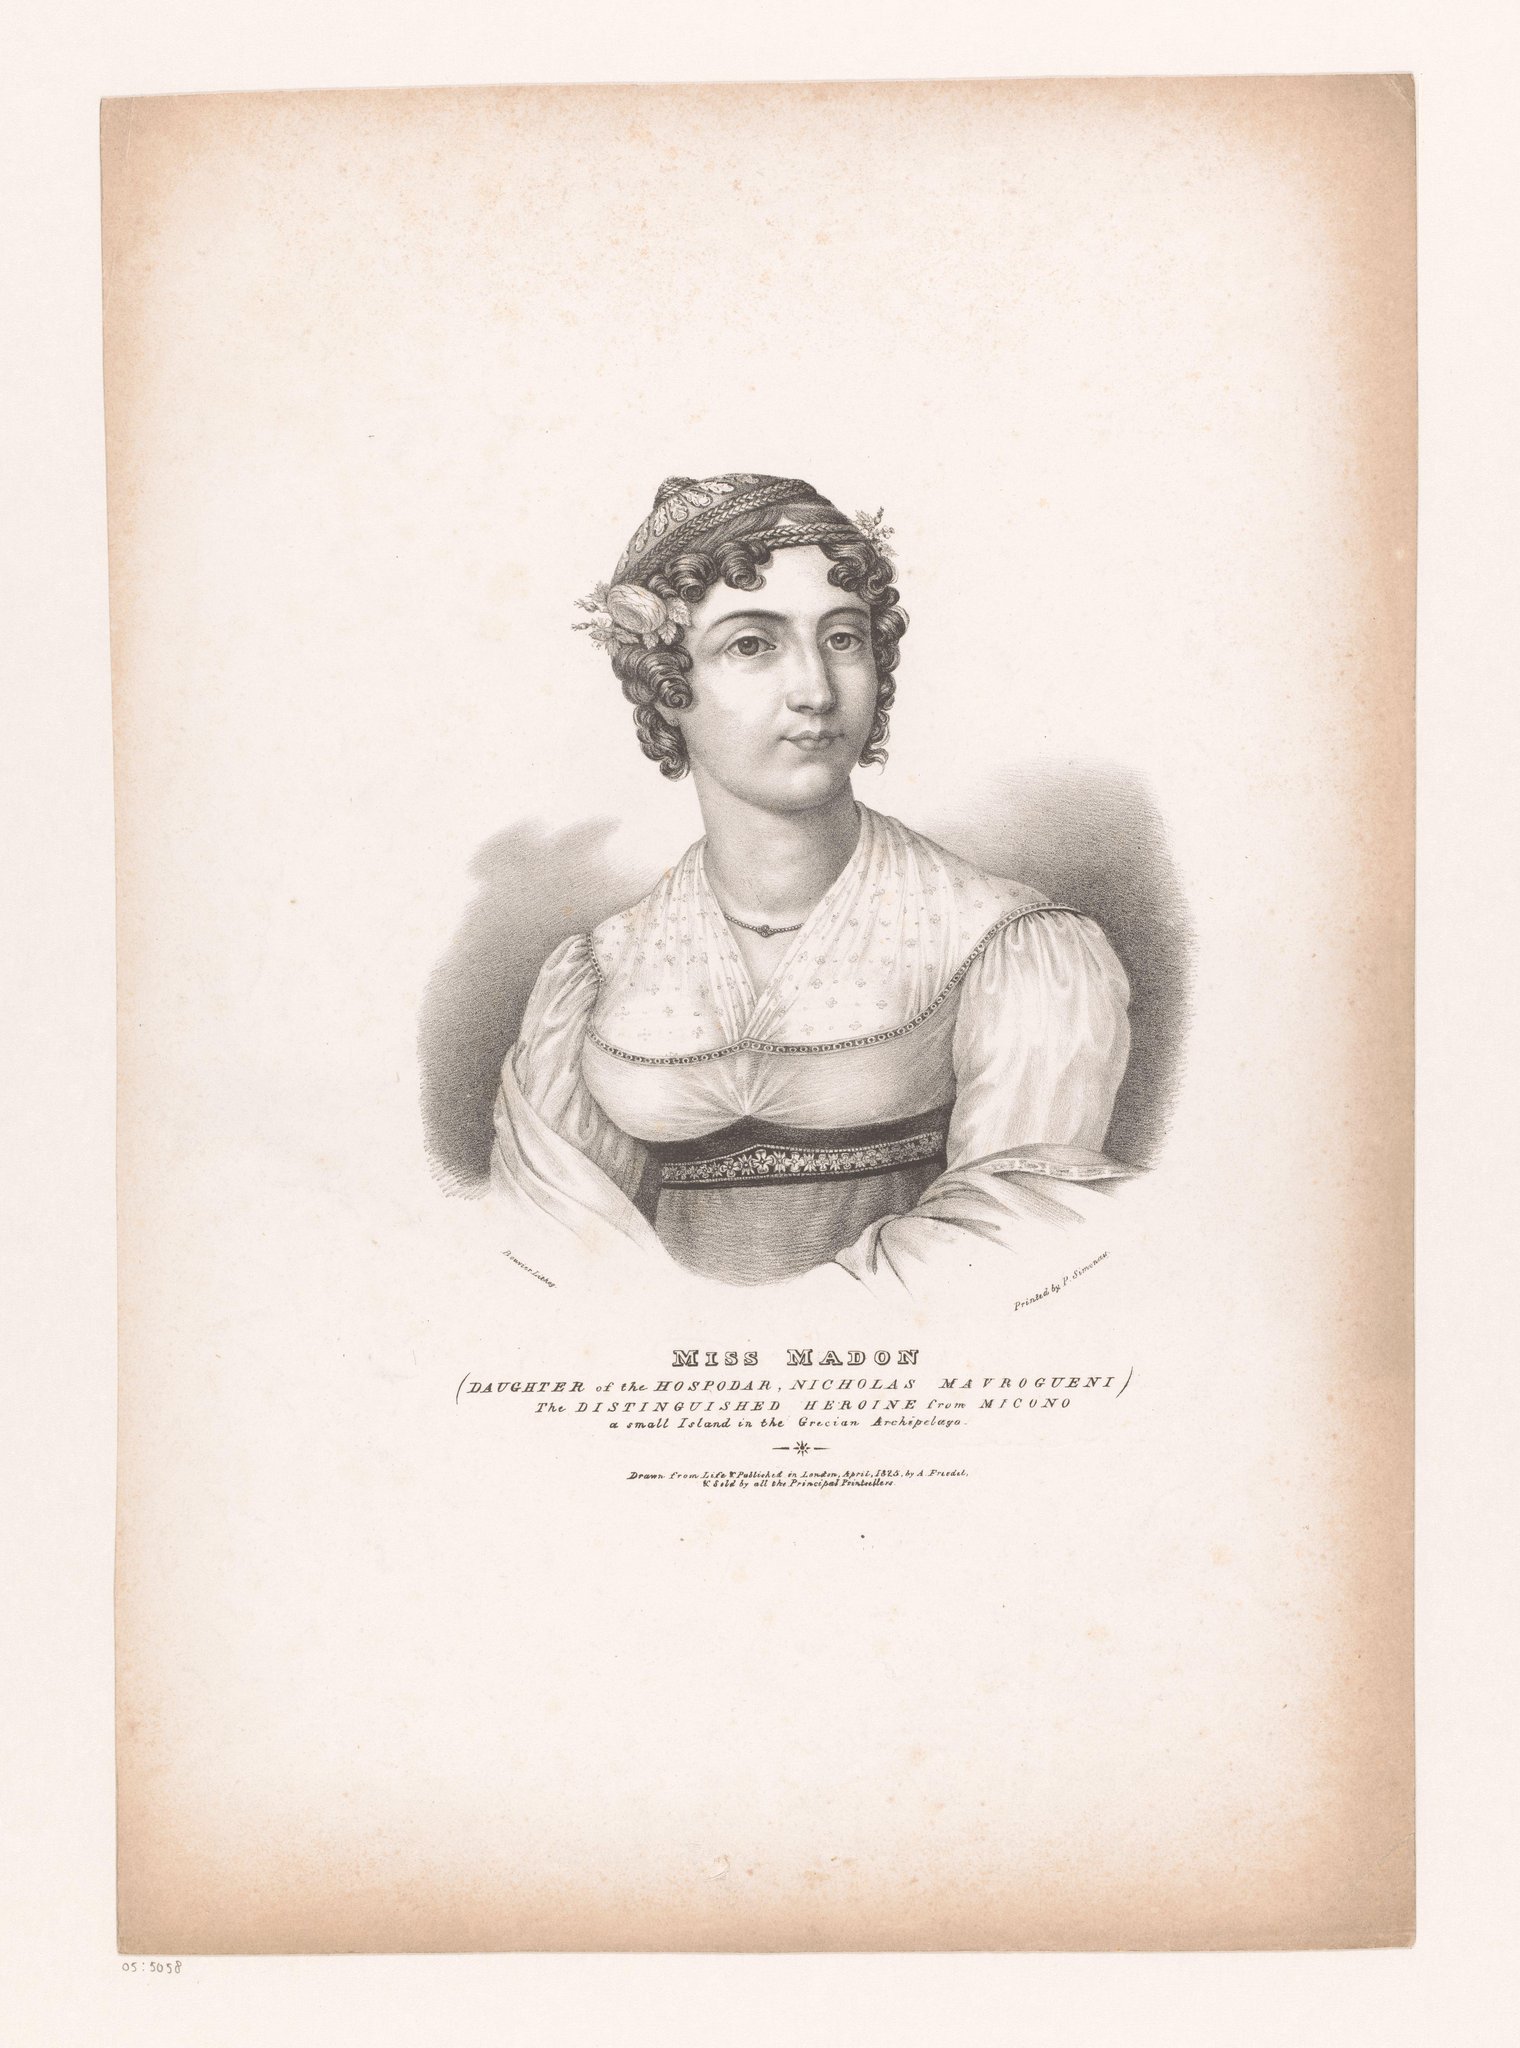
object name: print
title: Portret van Manto Mavrogenous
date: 1825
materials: paper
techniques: lithograph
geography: london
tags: adult woman, historical persons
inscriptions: collector's mark: Lugt 2228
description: Prent behoort mogelijk tot een serie portretten van figuren betrokken bij de Griekse onafhankelijkheidsoorlog.